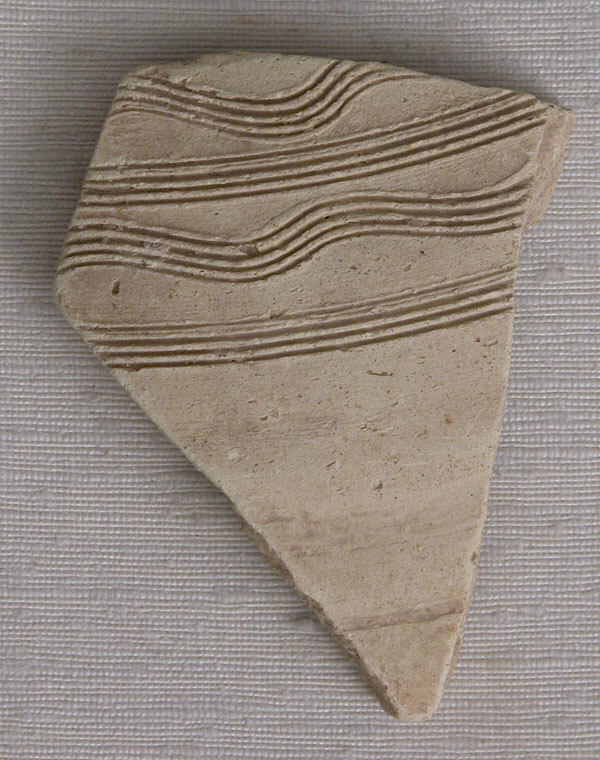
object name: fragment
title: Ceramic Fragment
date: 701-900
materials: earthenware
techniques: incising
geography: iraq